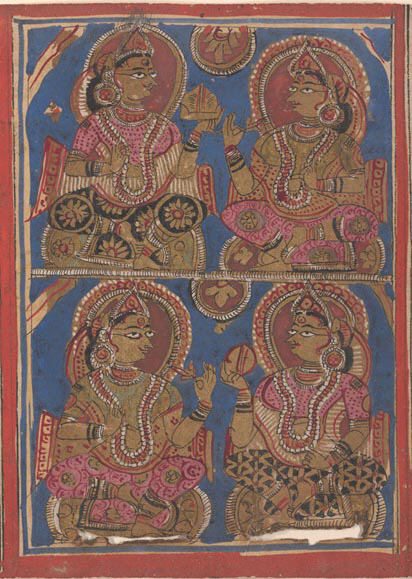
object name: folio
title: Vigil on the Sixth Night after Mahavira's Birth: Folio from a Kalpasutra Manuscript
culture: indian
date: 1401-1500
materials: gold, ink, paper, watercolor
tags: women